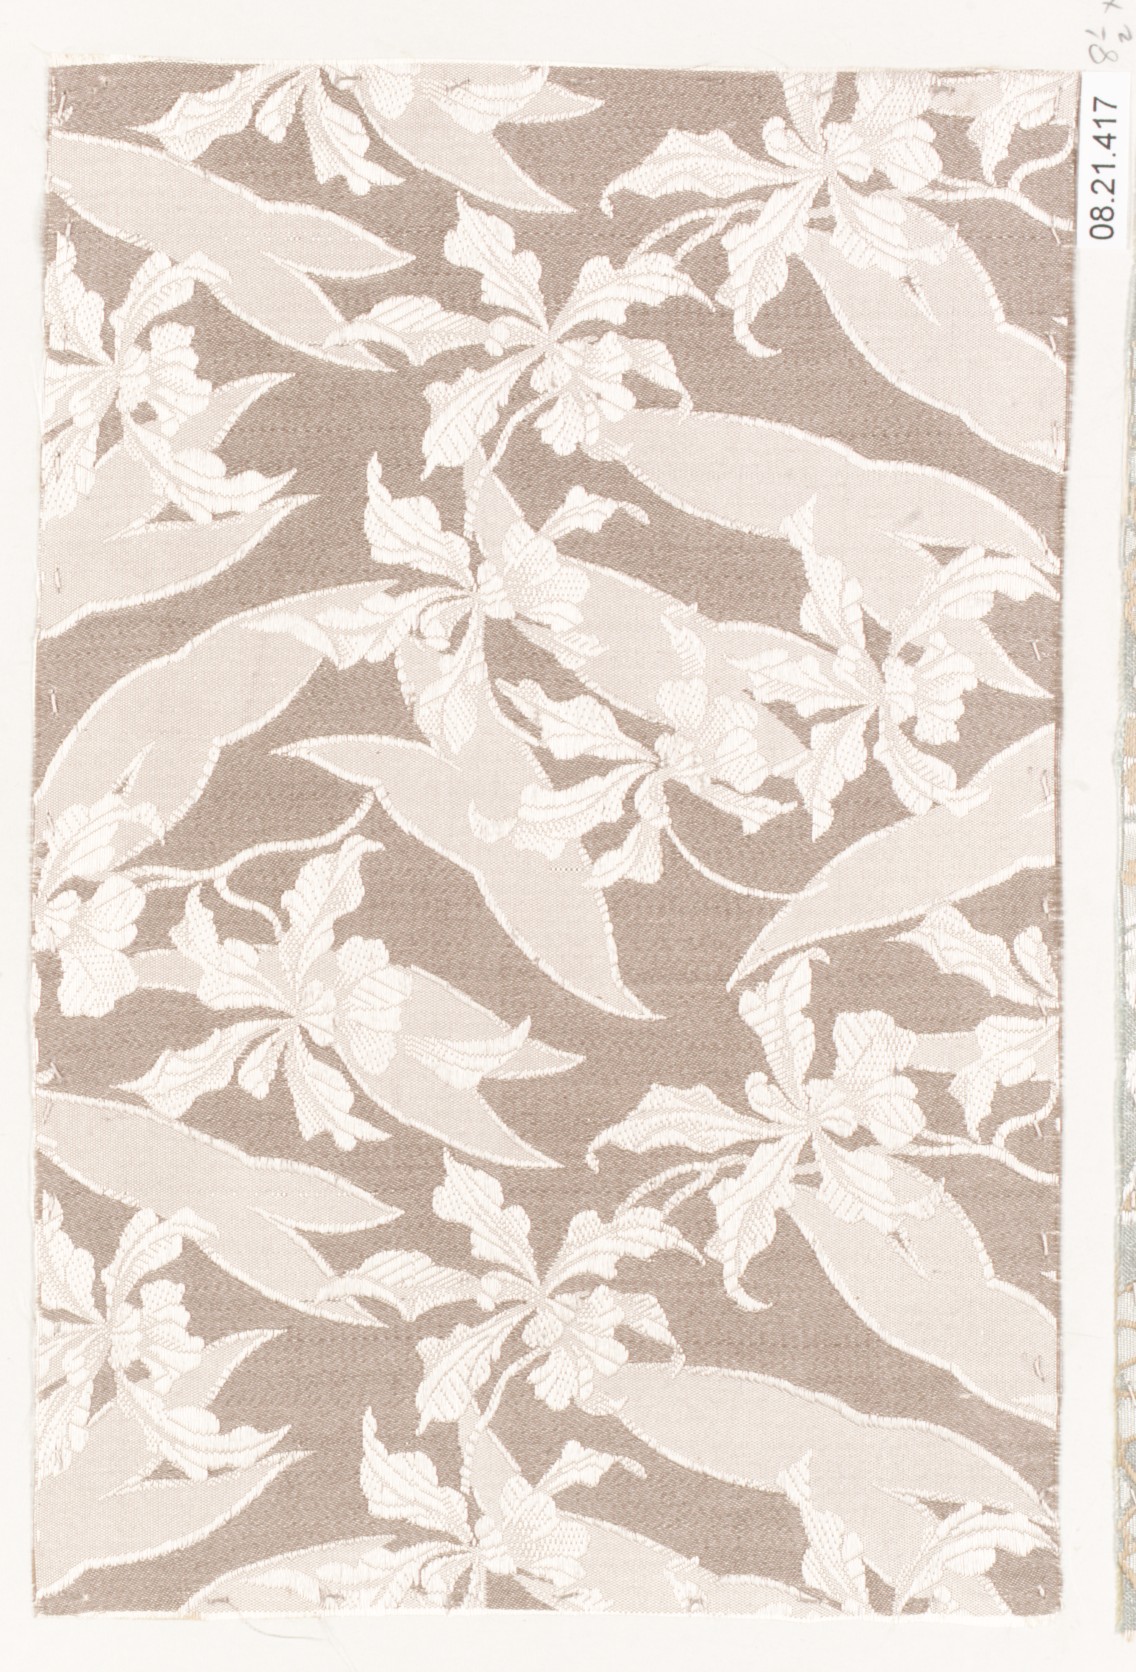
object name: textile sample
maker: Anonymous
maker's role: designer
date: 1900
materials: silk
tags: leaves